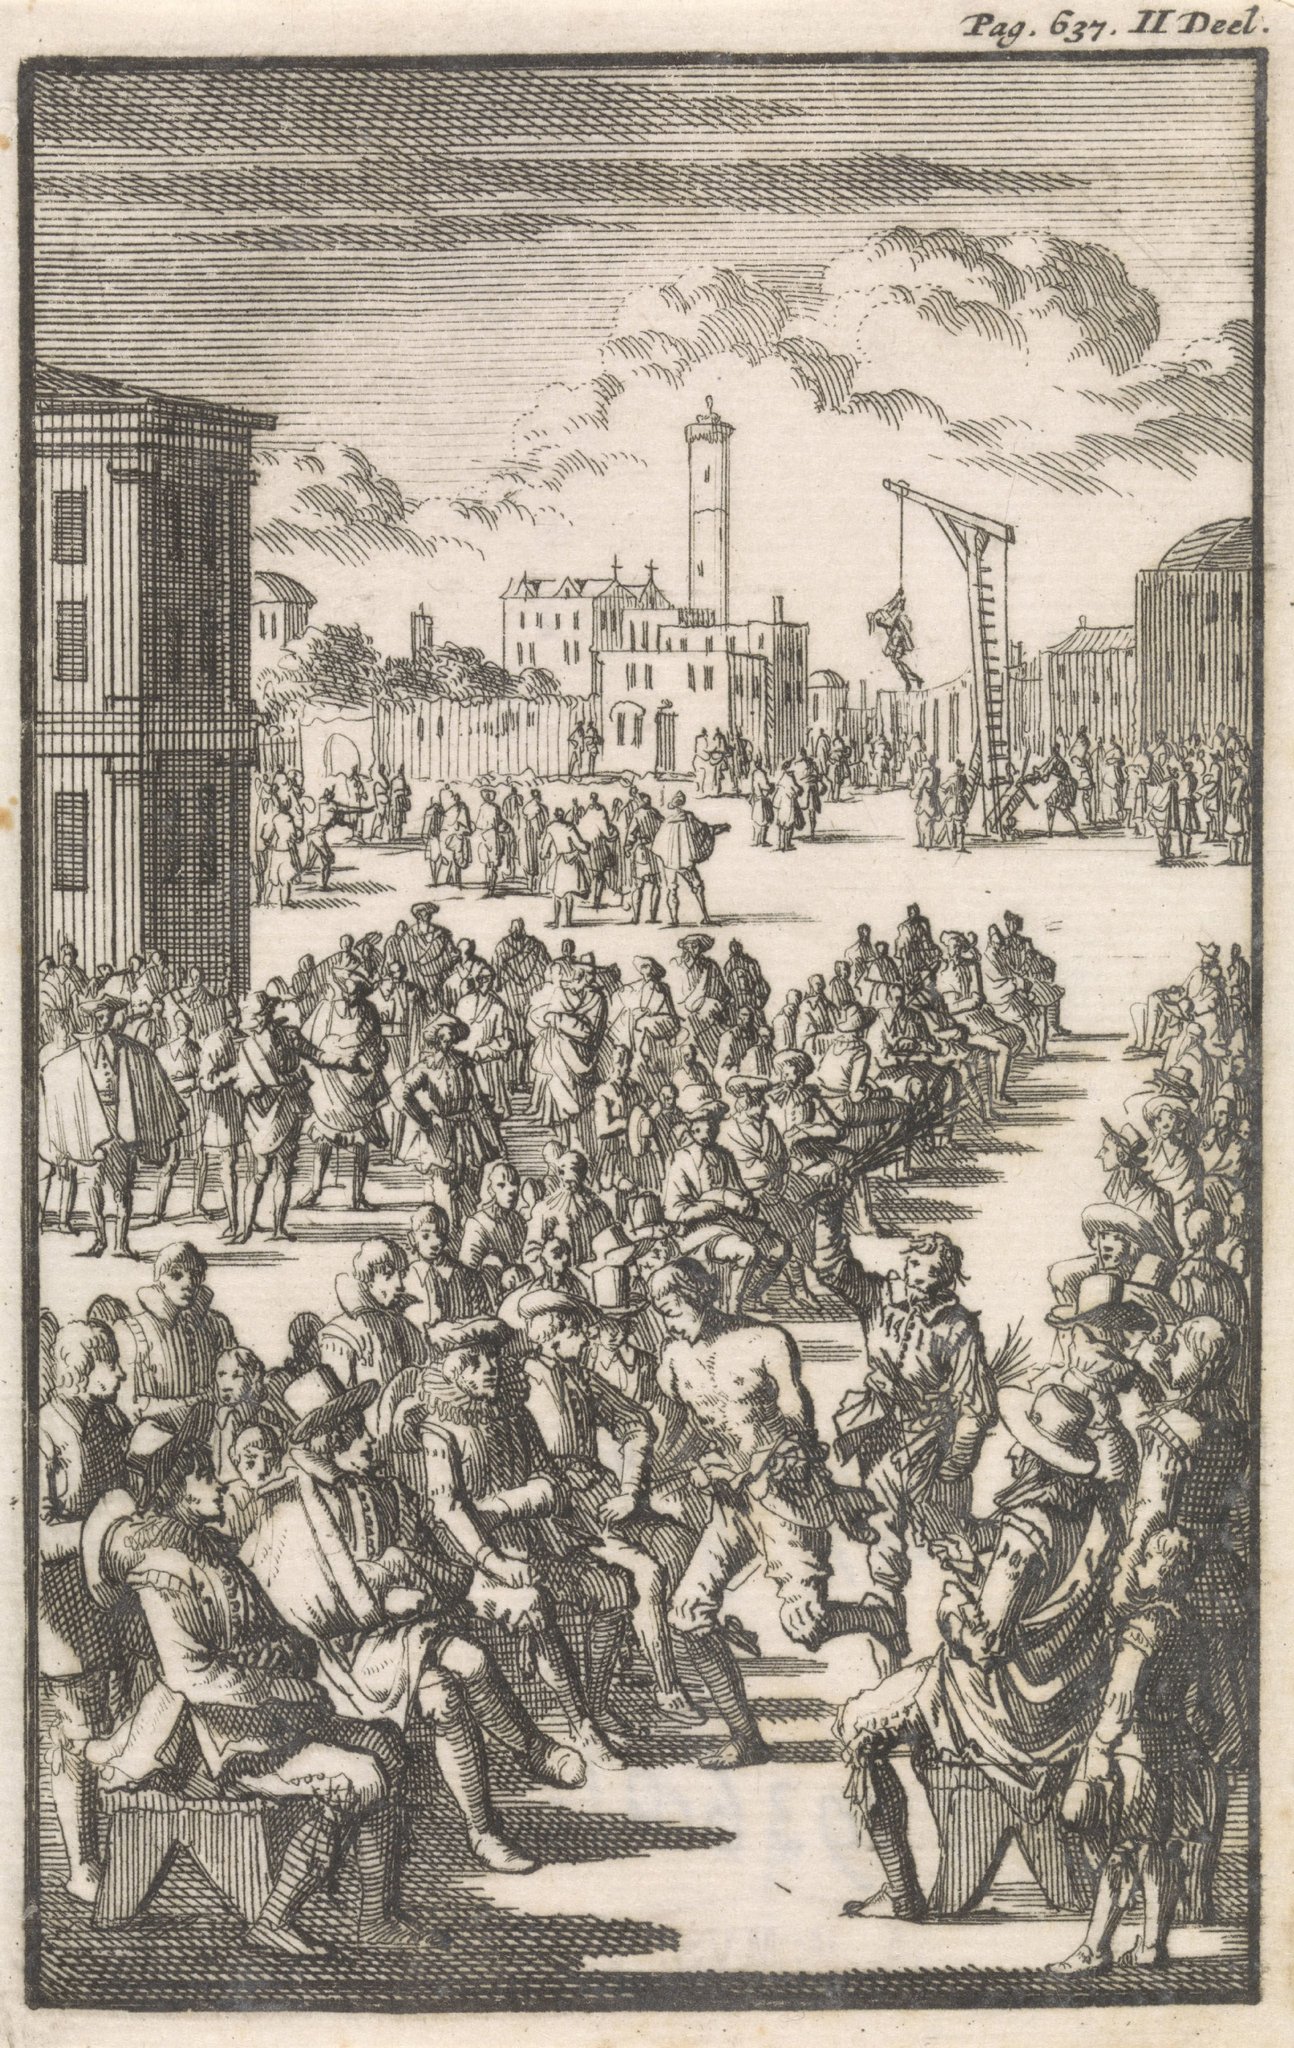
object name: print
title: Barbier Philippo Martioli wordt in het bijzijn van zijn vakgenoten gegegeseld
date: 1697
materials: paper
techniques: etching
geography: amsterdam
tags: flogging, scourging (in public), barber, barbershop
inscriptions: collector's mark: Lugt 2228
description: Illustratie uit: Leti, Gregorio. Het leeven van Sixtus den Vyfden, paus van Rome, 2 delen. Gillis en Johannes Janssonius van Waesberge en wed. Steven Swart, 1697, dl. II.